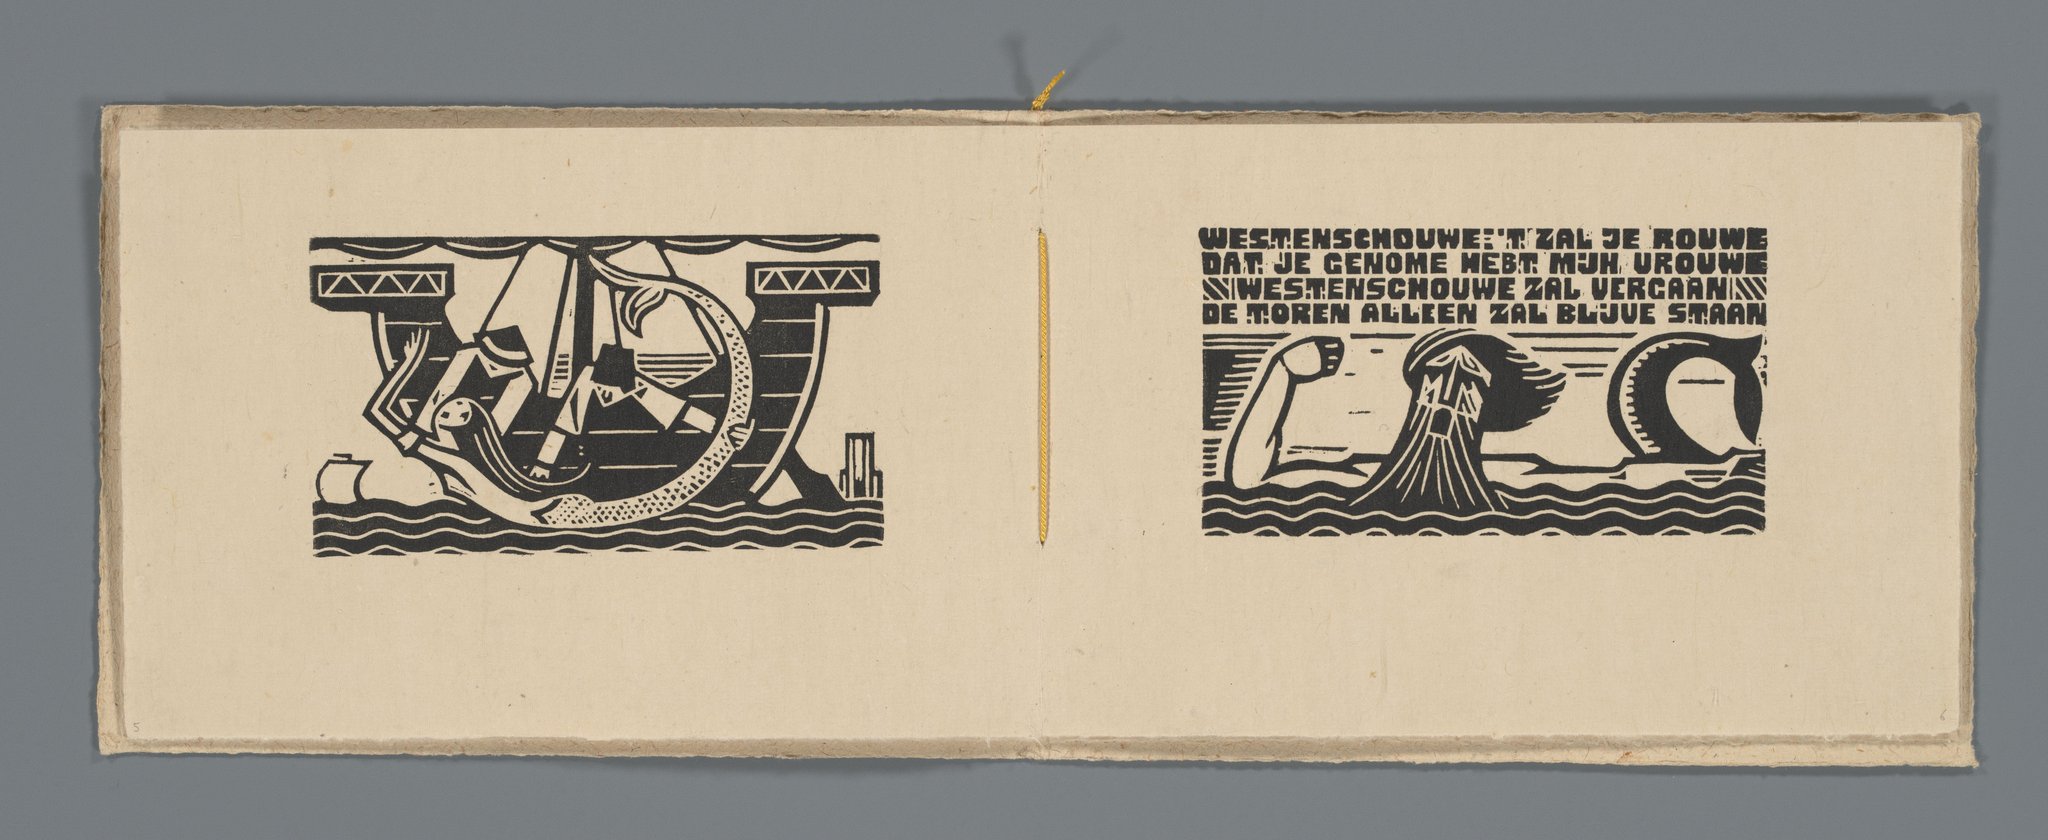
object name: print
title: Gevangen zeemeermin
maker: jan heyse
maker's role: painter, print maker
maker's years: 1882-1954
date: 1930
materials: paper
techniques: woodcut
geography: veere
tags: sailing-ship, sailing-boat, merman - aa - mermaid, siren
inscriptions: date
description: Twee figuren op een schip halen een zeemeermin uit het water. Onderdeel van album 'Westenschouwe'.